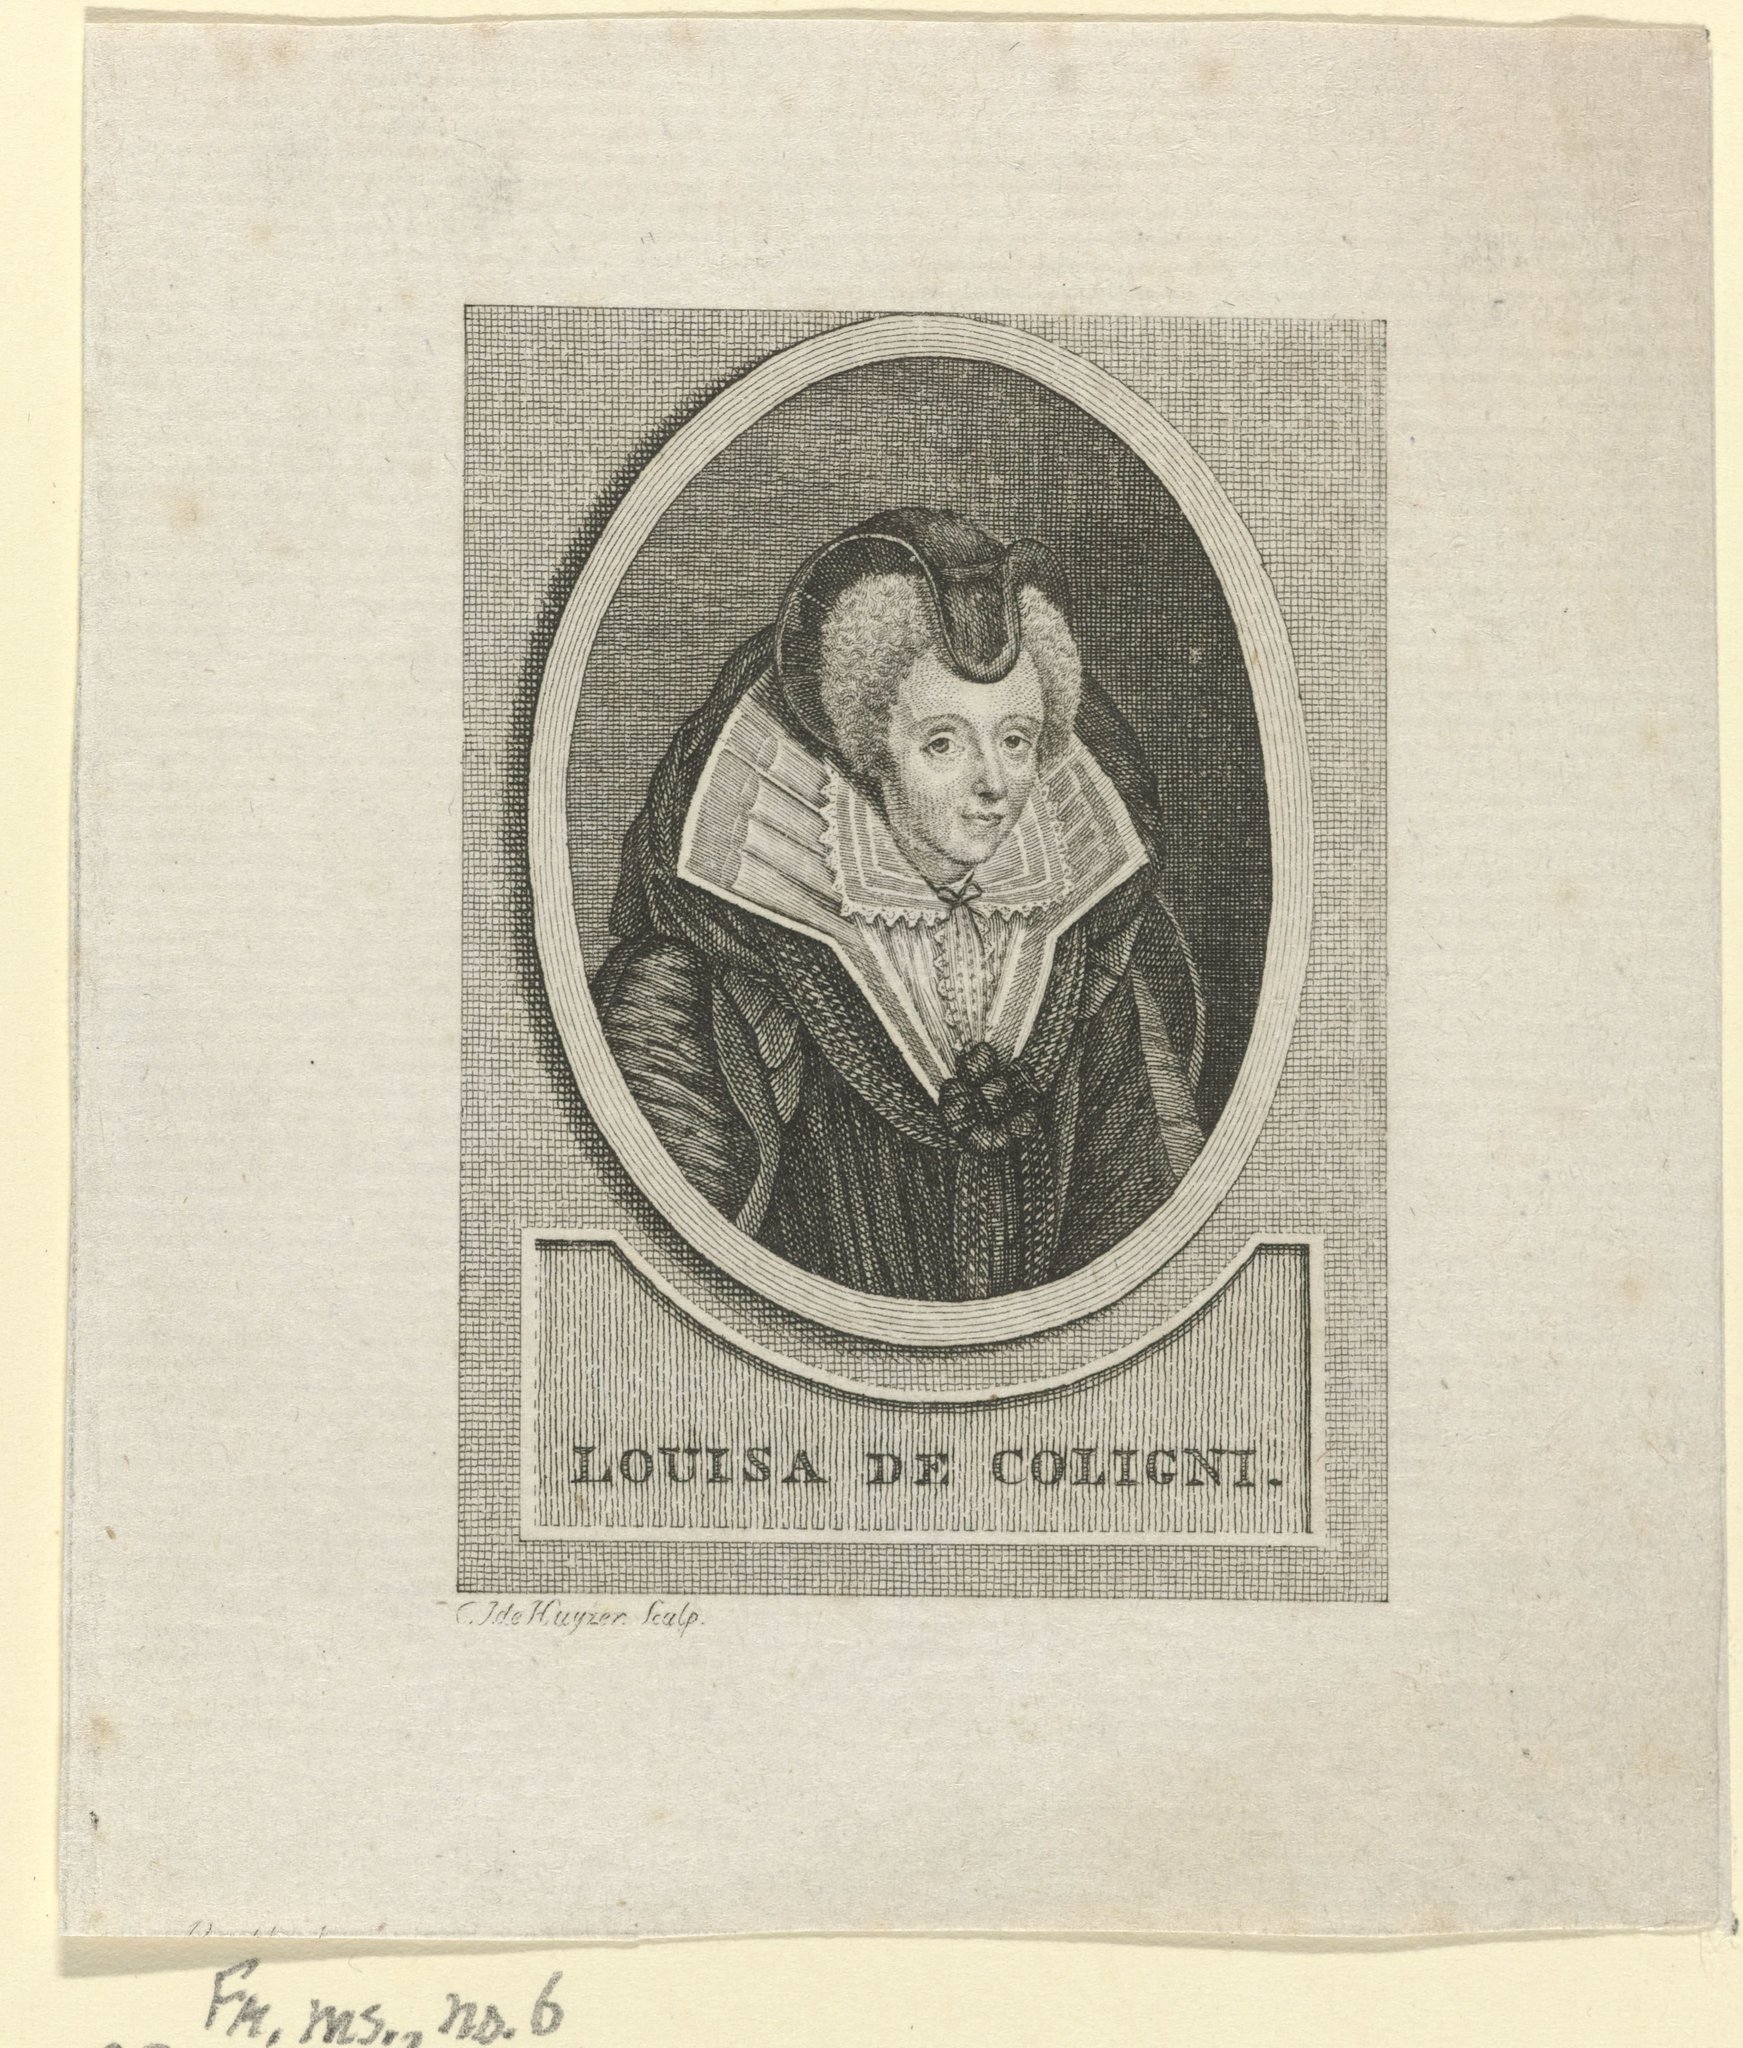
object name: print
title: Portret van Louise de Coligny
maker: carel jacob de huyser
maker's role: print maker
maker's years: 1743-1804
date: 1763-1804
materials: paper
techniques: engraving, etching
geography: amsterdam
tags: louise de coligny, neck-gear: collar (+ women's clothes)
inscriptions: collector's mark: Lugt 963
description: Portret van Louise in een ovaal. In een kader haar naam.